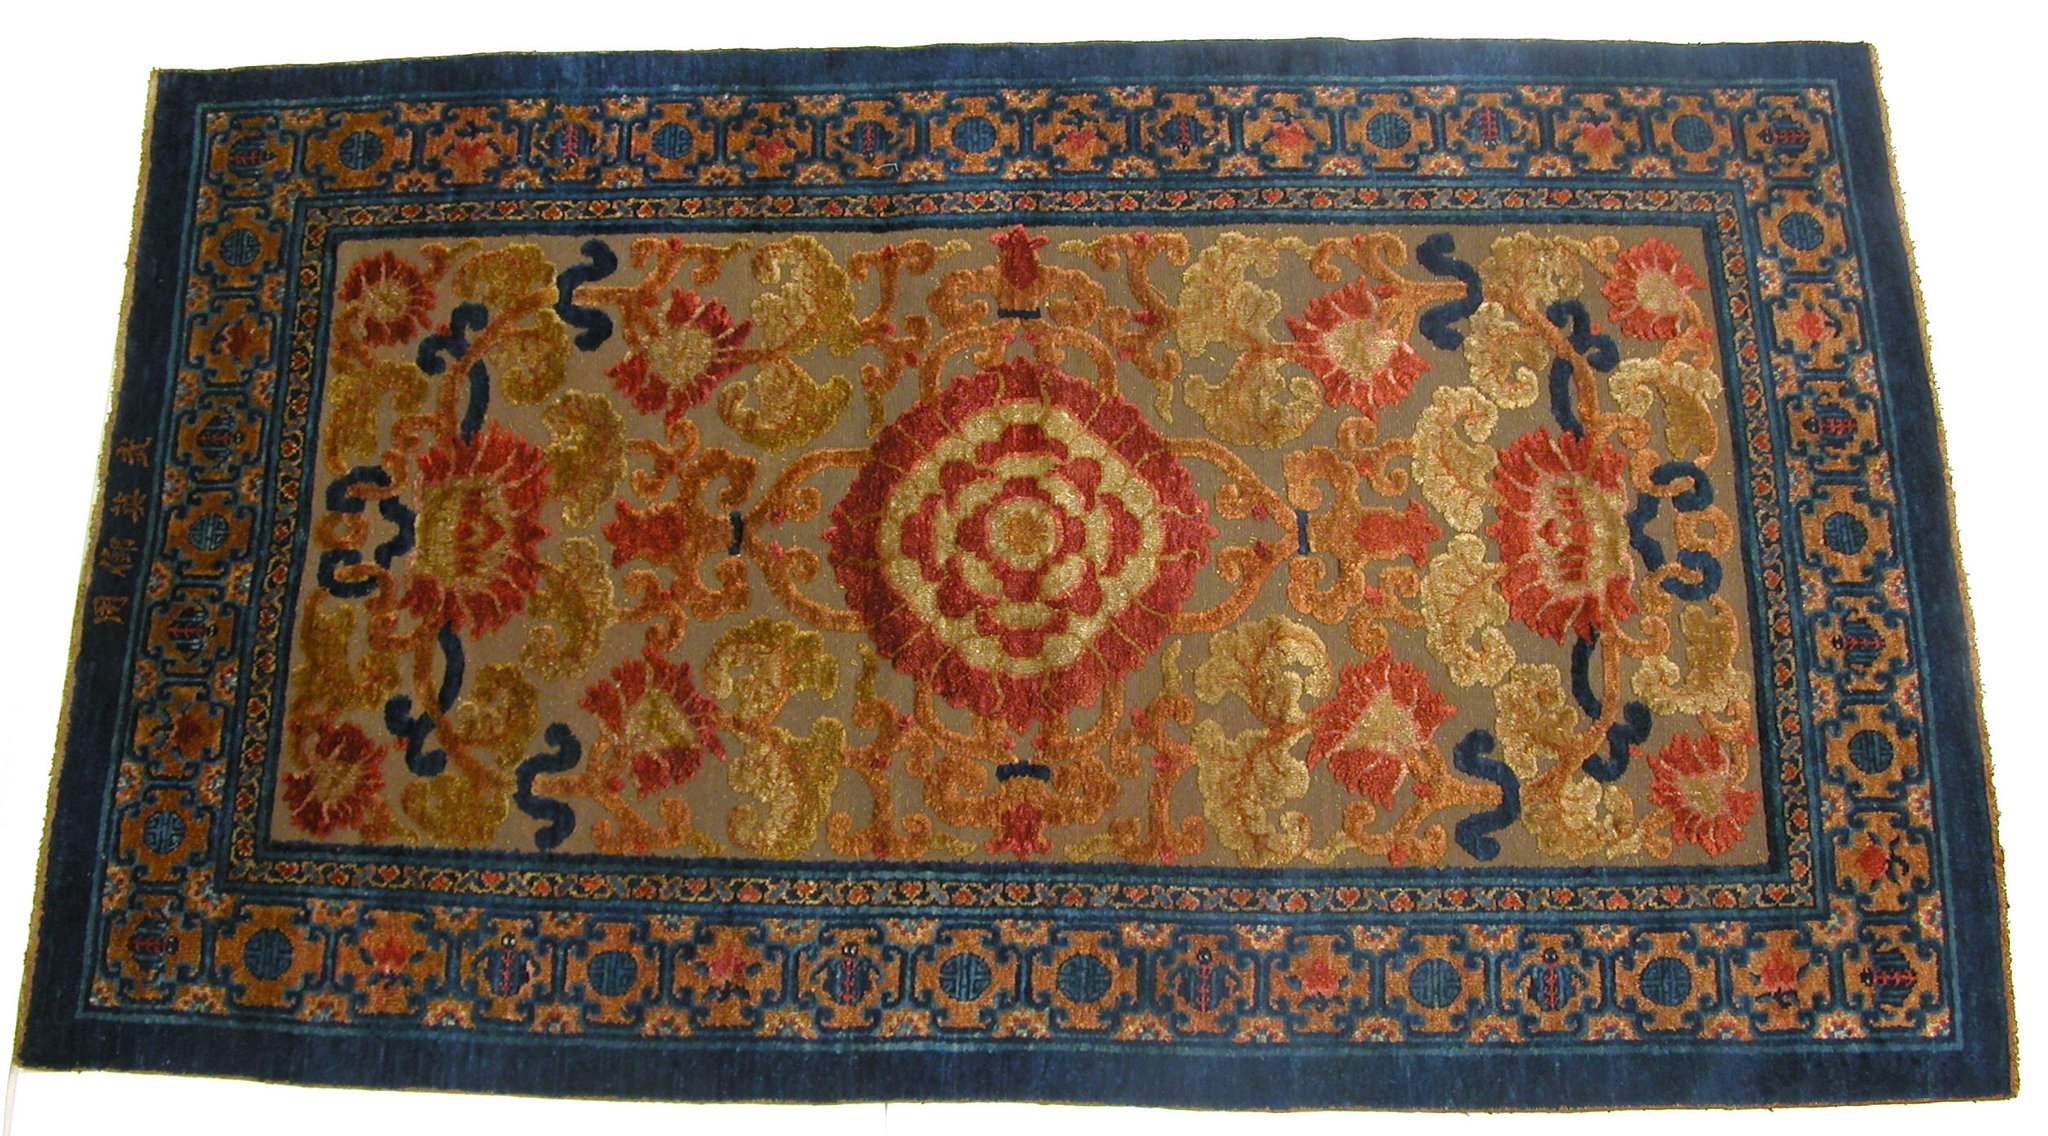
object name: rug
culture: chinese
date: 1867-1900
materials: cotton, metal thread, silk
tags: flowers